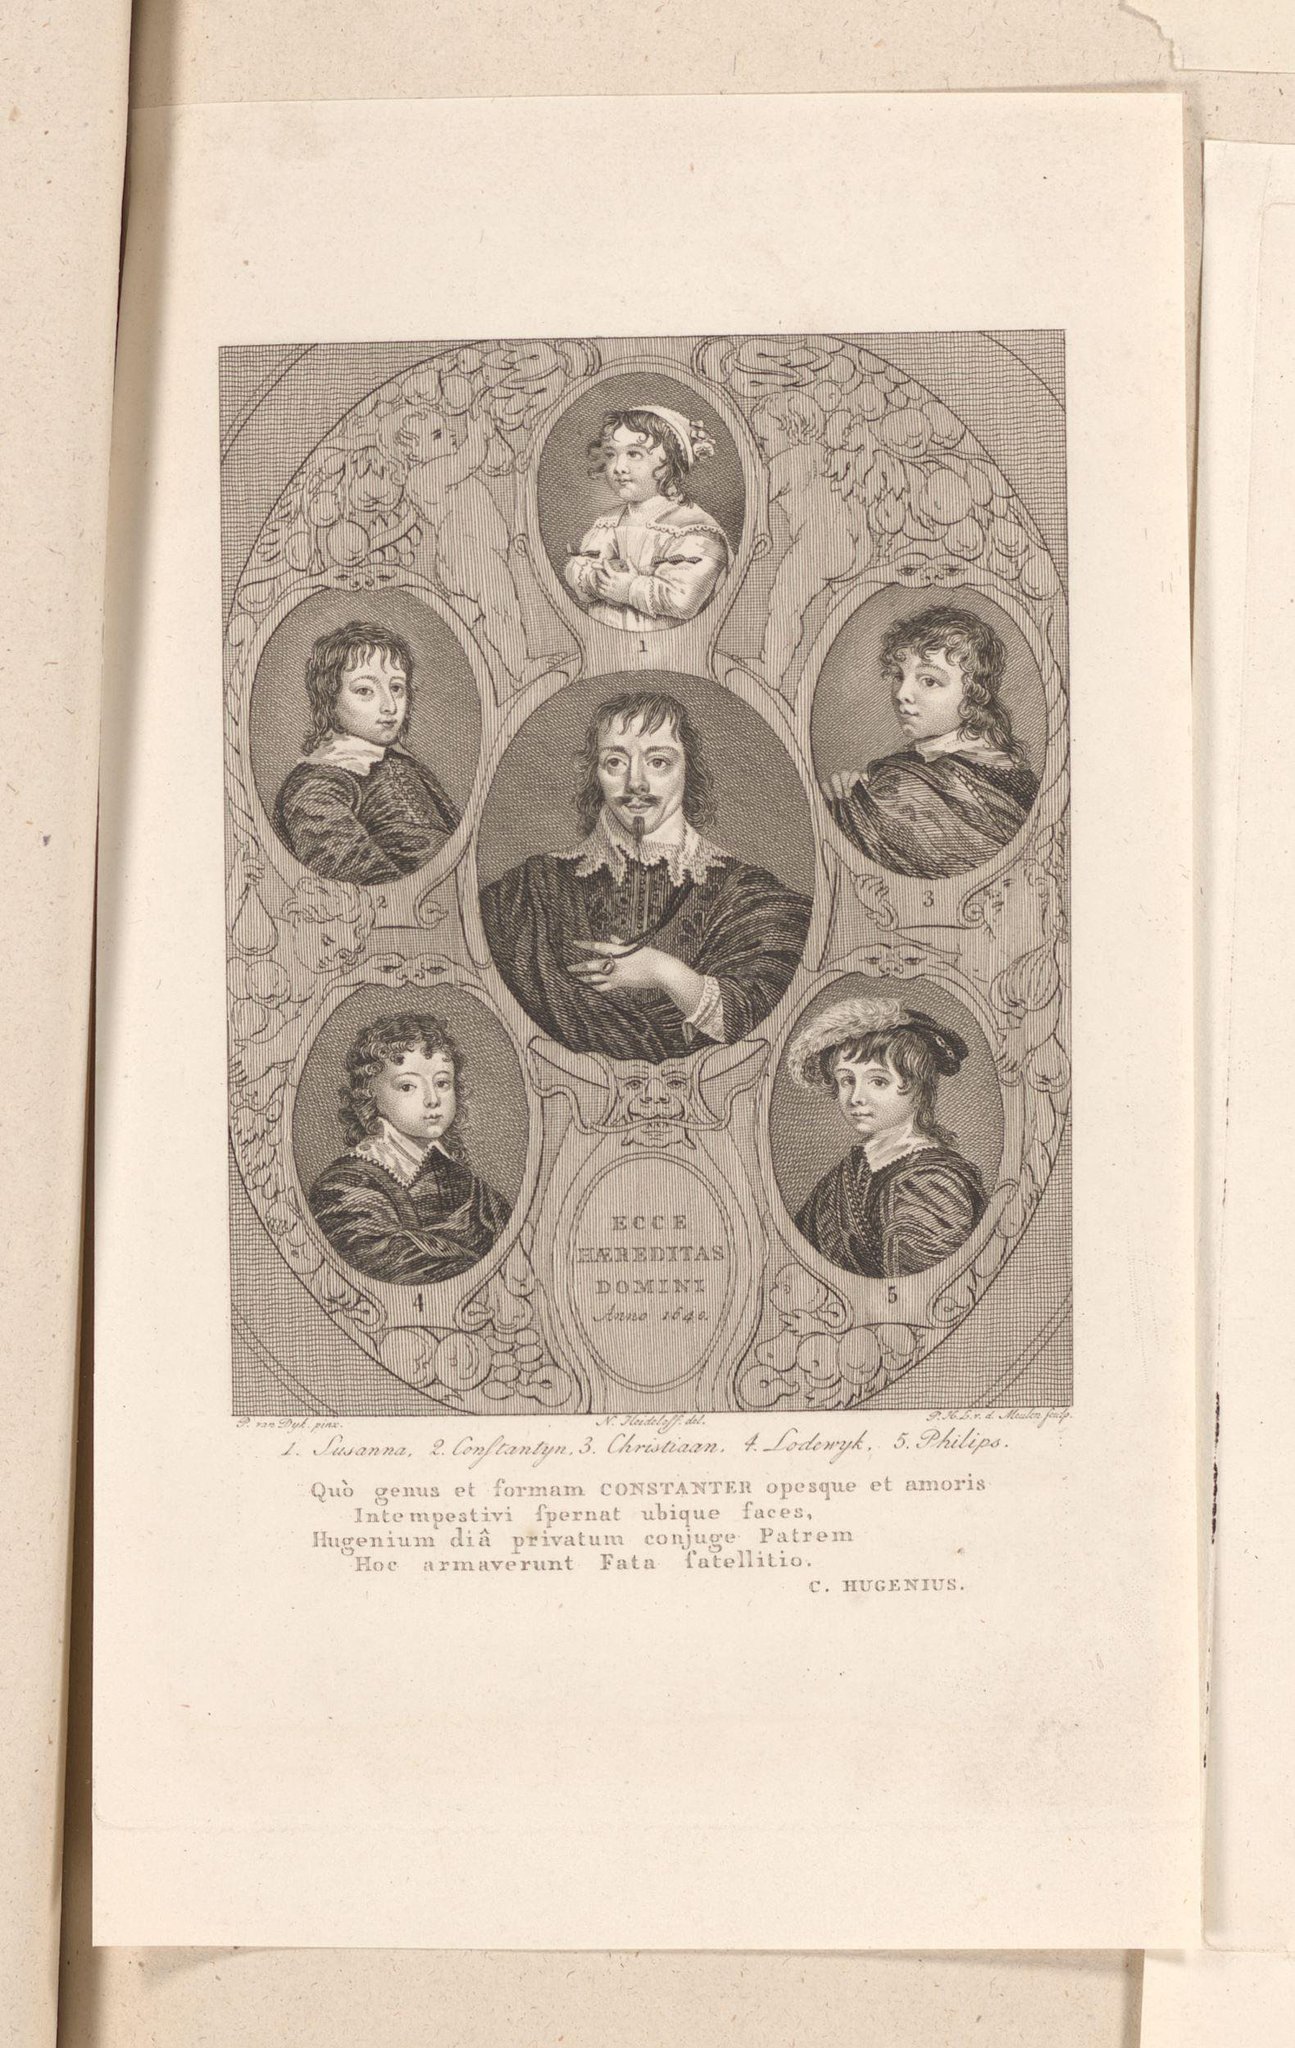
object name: album leaf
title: Portretten van Constantijn Huygens en zijn vijf kinderen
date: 1817-1818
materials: paper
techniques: etching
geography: haarlem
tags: constantijn huygens (i)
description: Mogelijk gebruikt als boekillustratie in: Constantini Hugenii De vita propria, sermonum inter liberos libri duo. Primum editit et annotatione illustravit Petrus Hofman Peerlkamp; belgicis versibus adumbravit Adrianus Loosjes. Haarlem: A. Loosjes, 1817.